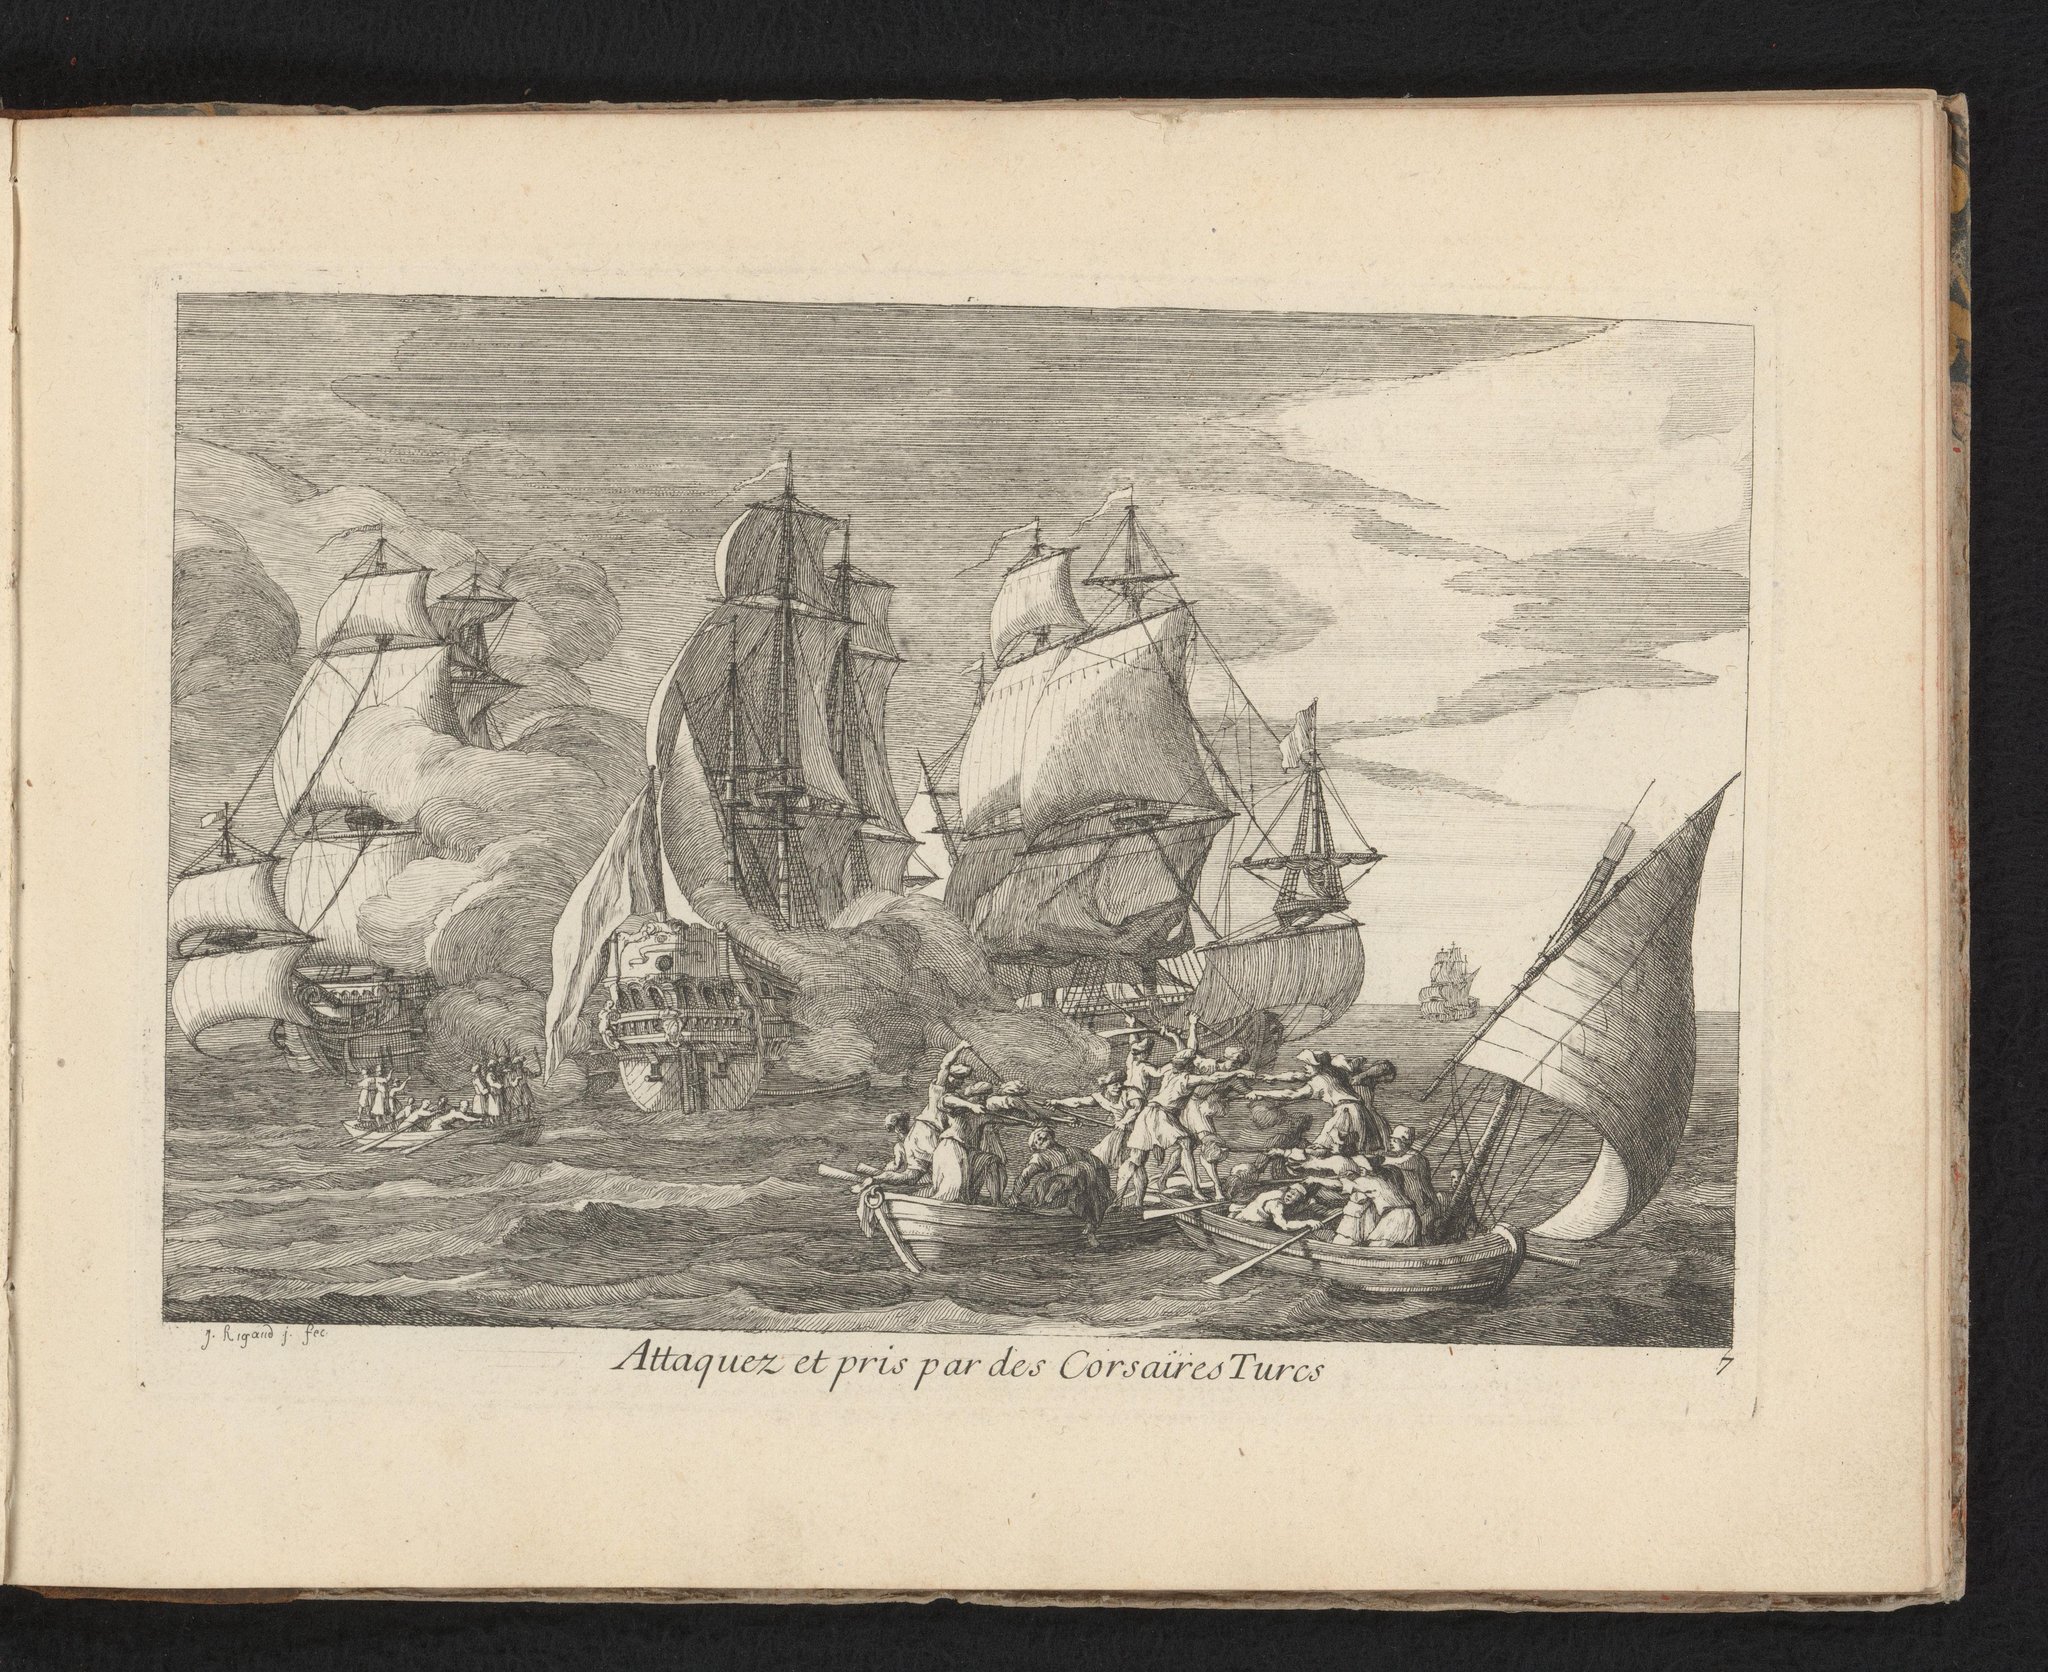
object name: print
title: Zeilschepen aangevallen door zeerovers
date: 1700-1725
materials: paper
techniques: etching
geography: paris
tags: pirate, corsair, buccaneer, sailing-ship, sailing-boat, traveller(s) attacked by robber(s) (+ propulsion of vehicle, ship, etc. by ...)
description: Deze prent maakt deel uit van een album.